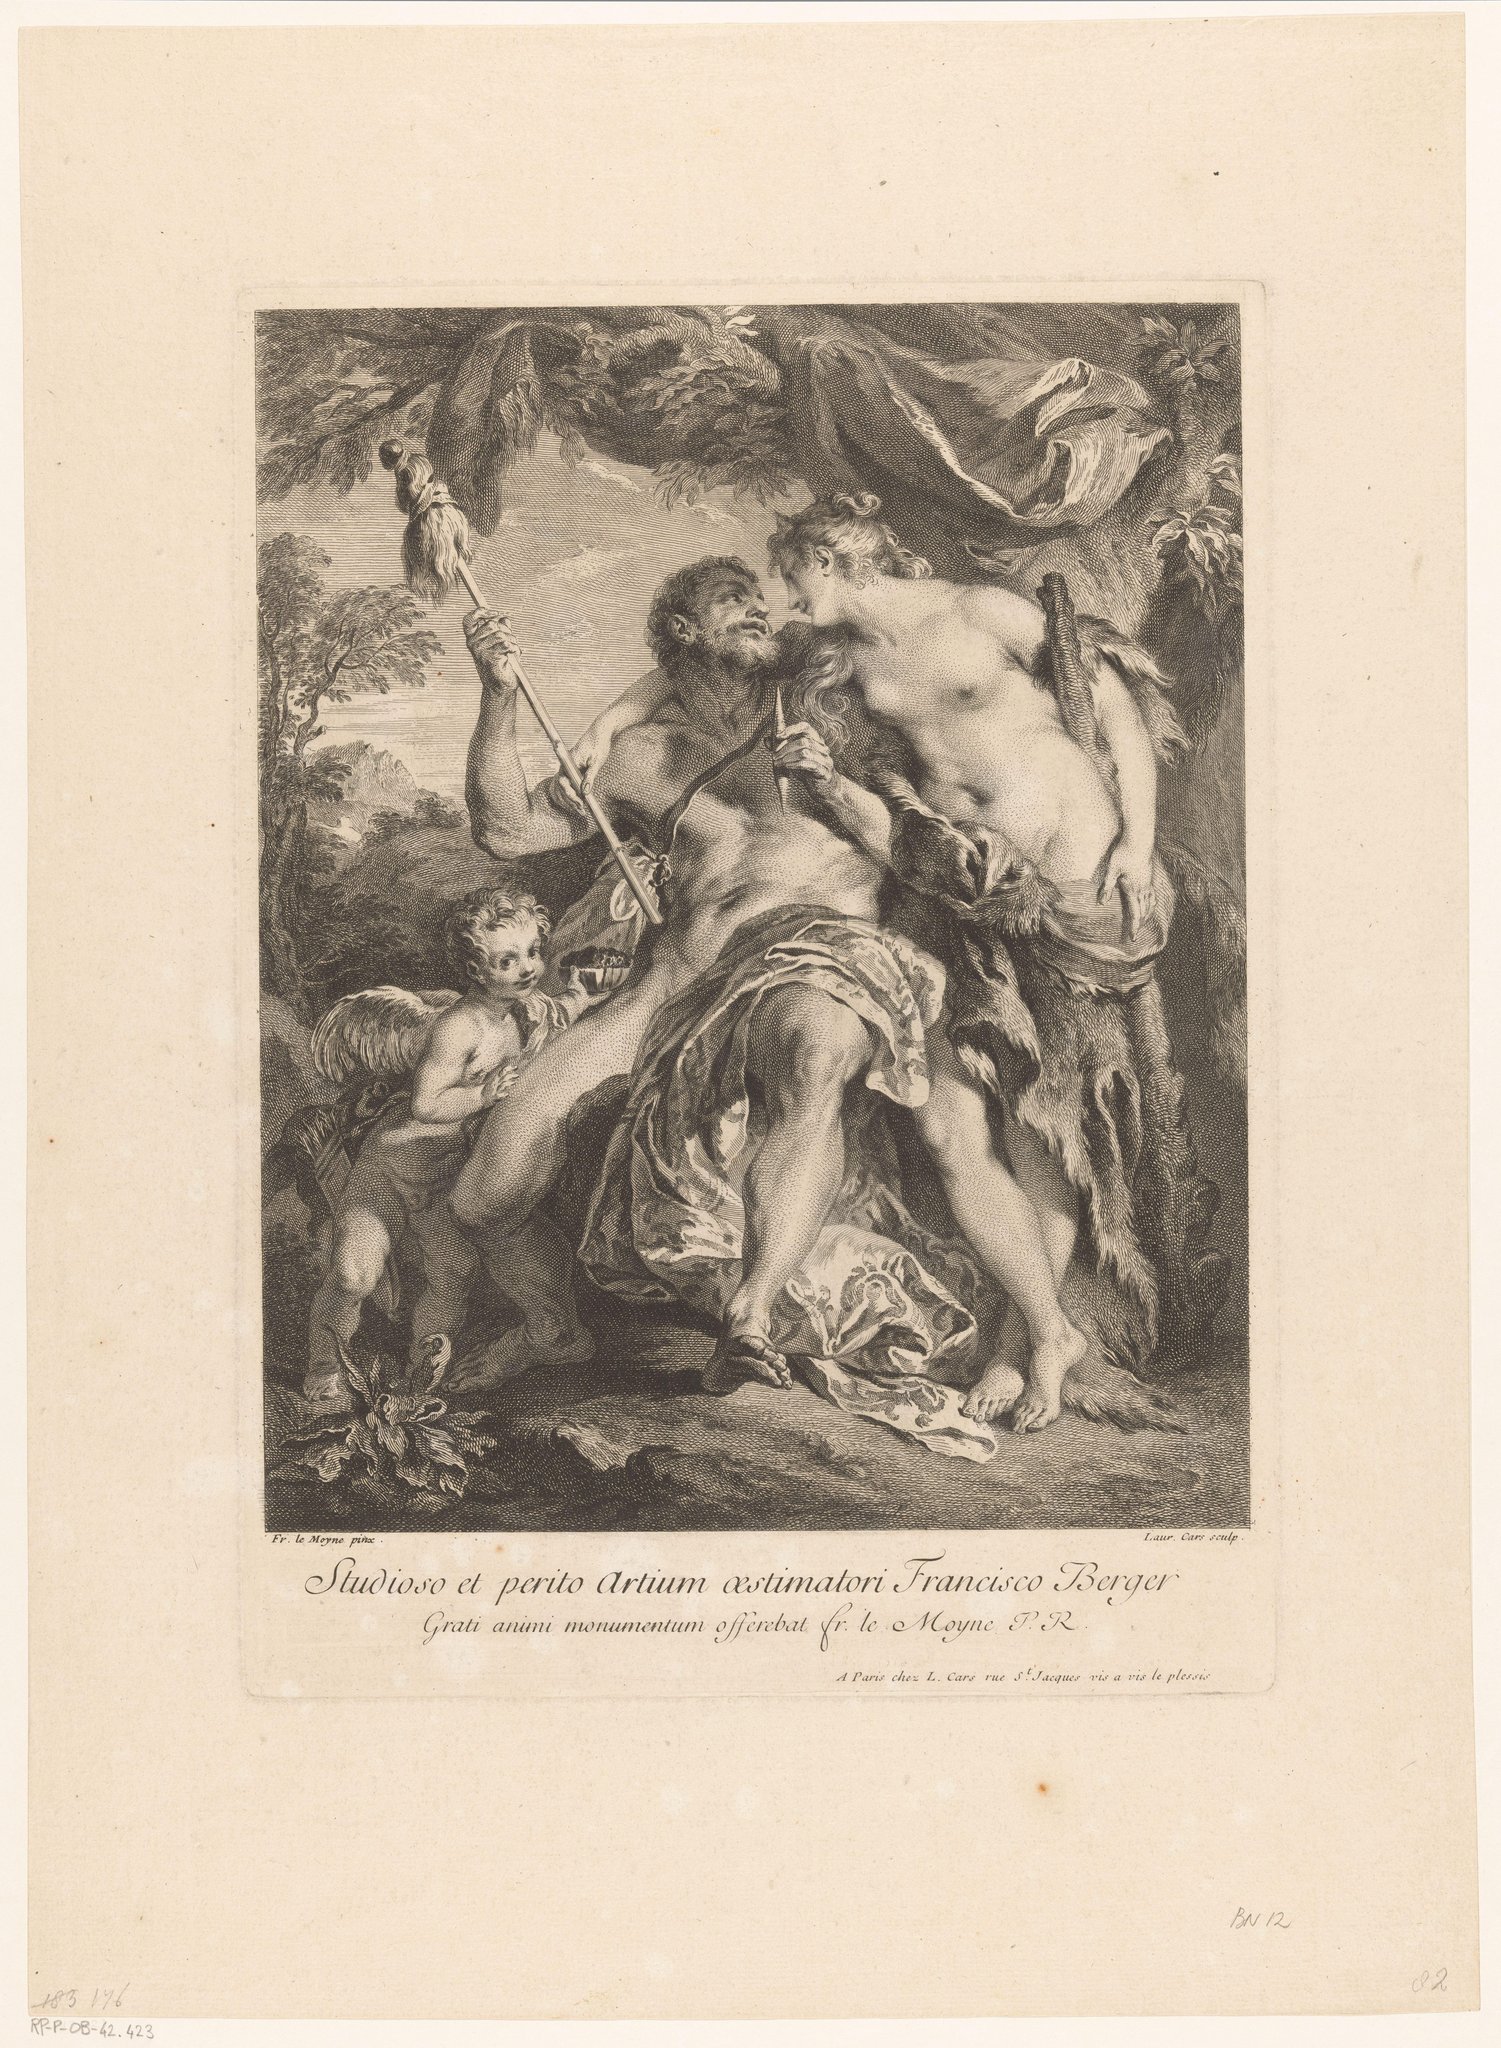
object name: print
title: Hercules en Omphale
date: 1728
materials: paper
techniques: engraving, etching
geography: france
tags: hercules in love with omphale; the hero is set to spin wool or to do other women's work among the servants, while omphale wears his lion's skin and wields his club and bow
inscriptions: collector's mark: Lugt 240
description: Het schilderij door Le Moine is 1724 gedateerd.